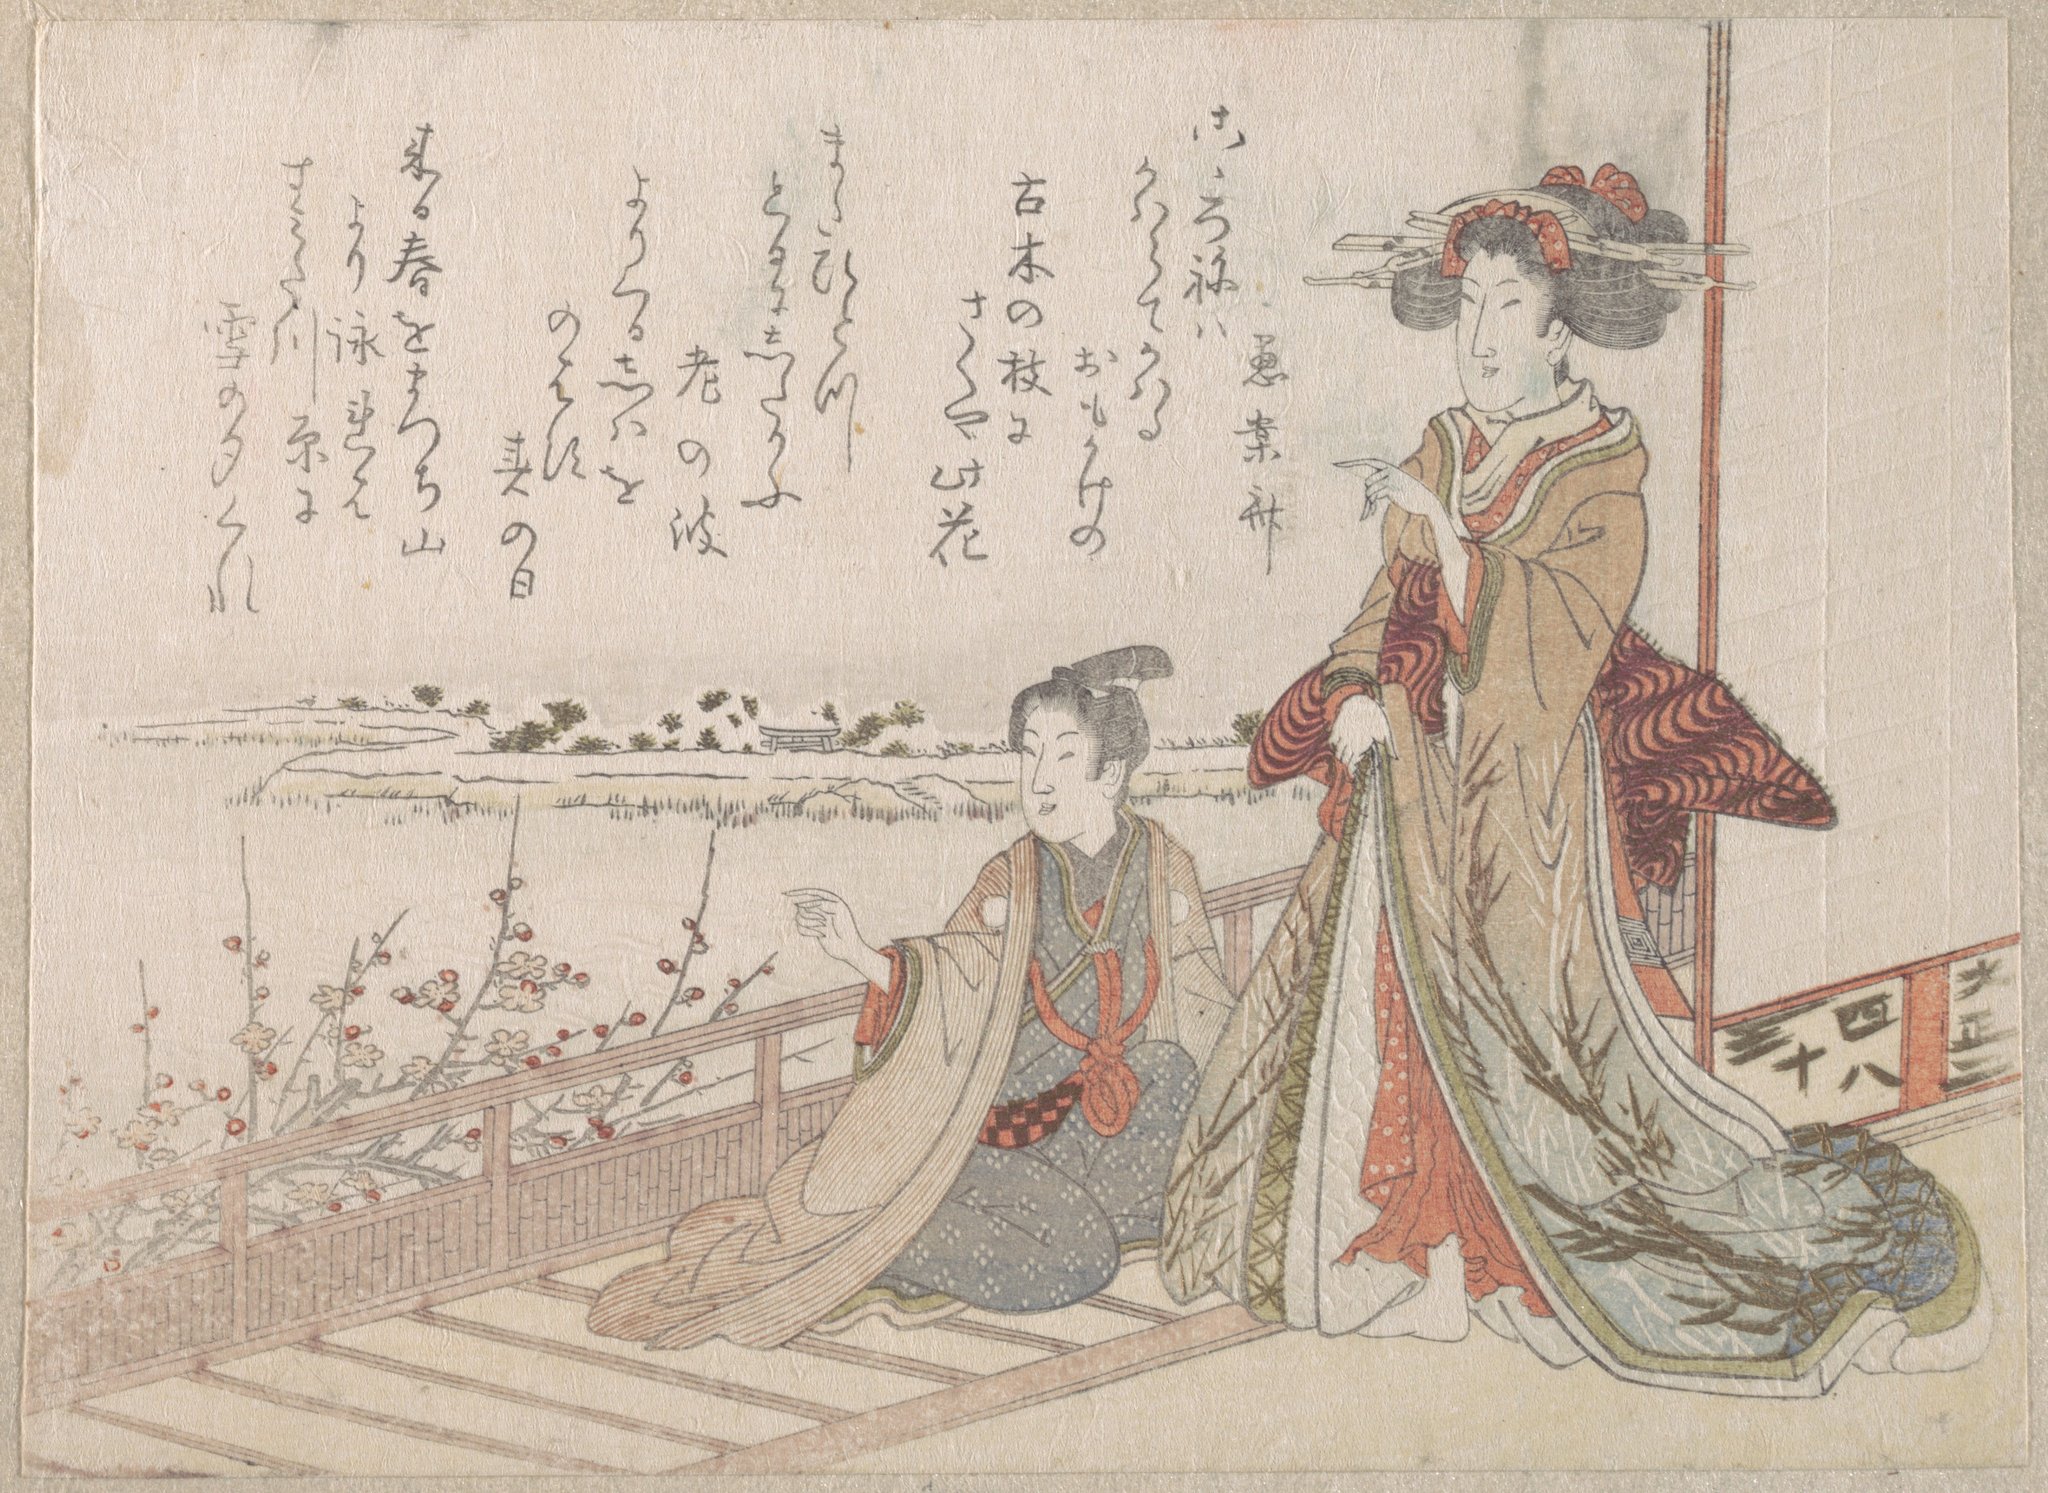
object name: print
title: Woman and Youth on a Verandah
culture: japanese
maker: unidentified artist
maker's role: artist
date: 1806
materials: ink, paper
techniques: surimono, woodblock print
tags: women